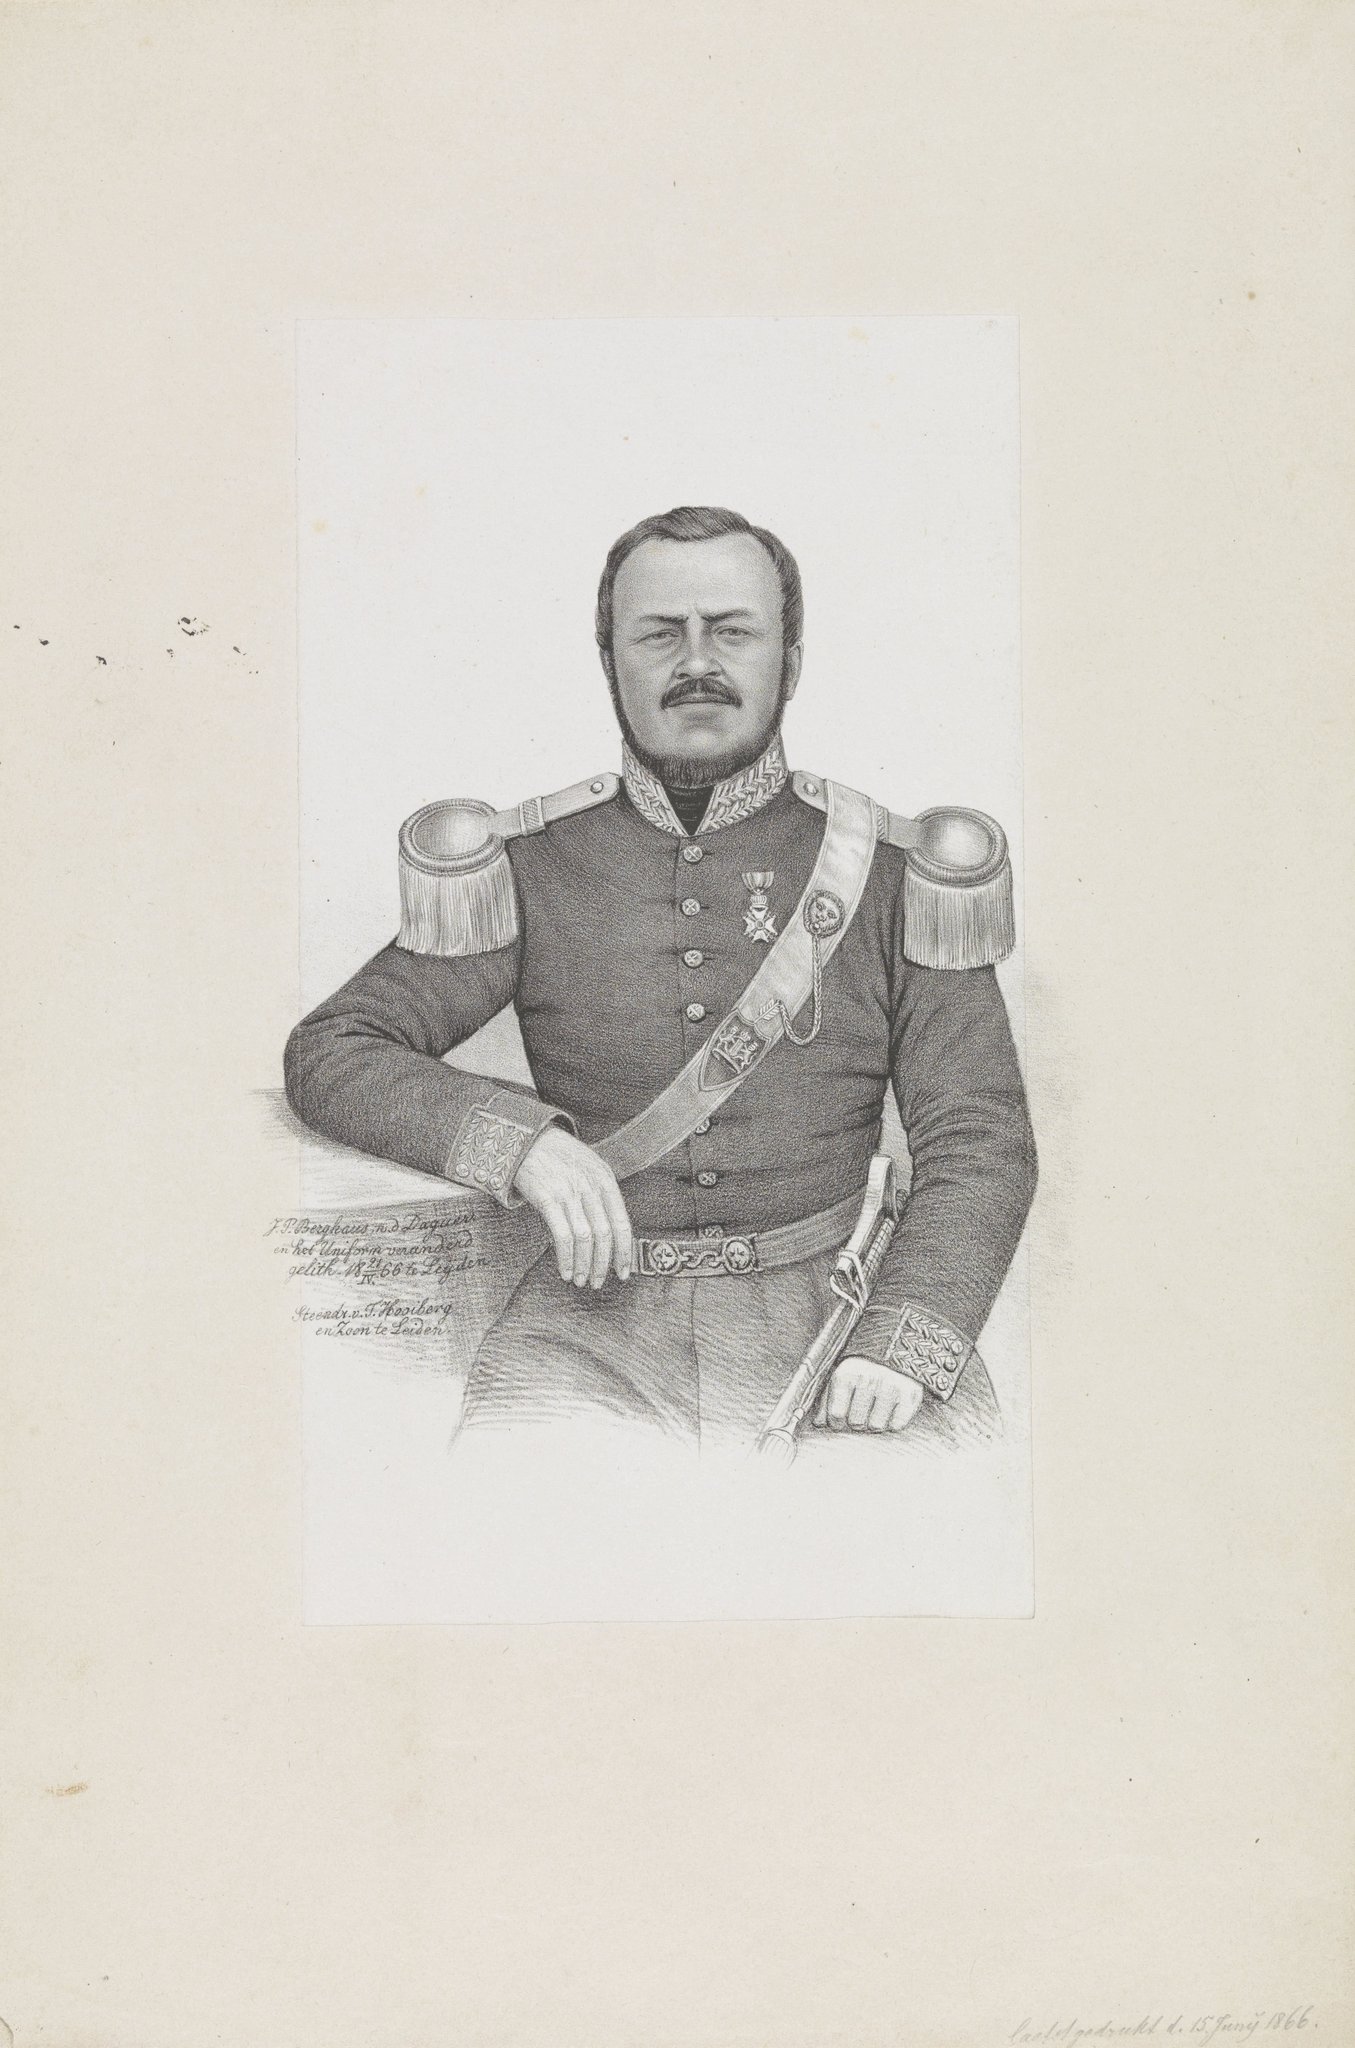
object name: print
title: Portret van een onbekende man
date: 1866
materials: paper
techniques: lithograph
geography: leiden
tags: knighthood order, hacking and thrusting weapons (with name), historical persons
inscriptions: collector's mark: Lugt 2228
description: De geportretteerde is frontaal afgebeeld en leunt met zijn rechterarm op een tafel. Hij draagt een militair kostuum met epauletten, decoraties en een sabel.